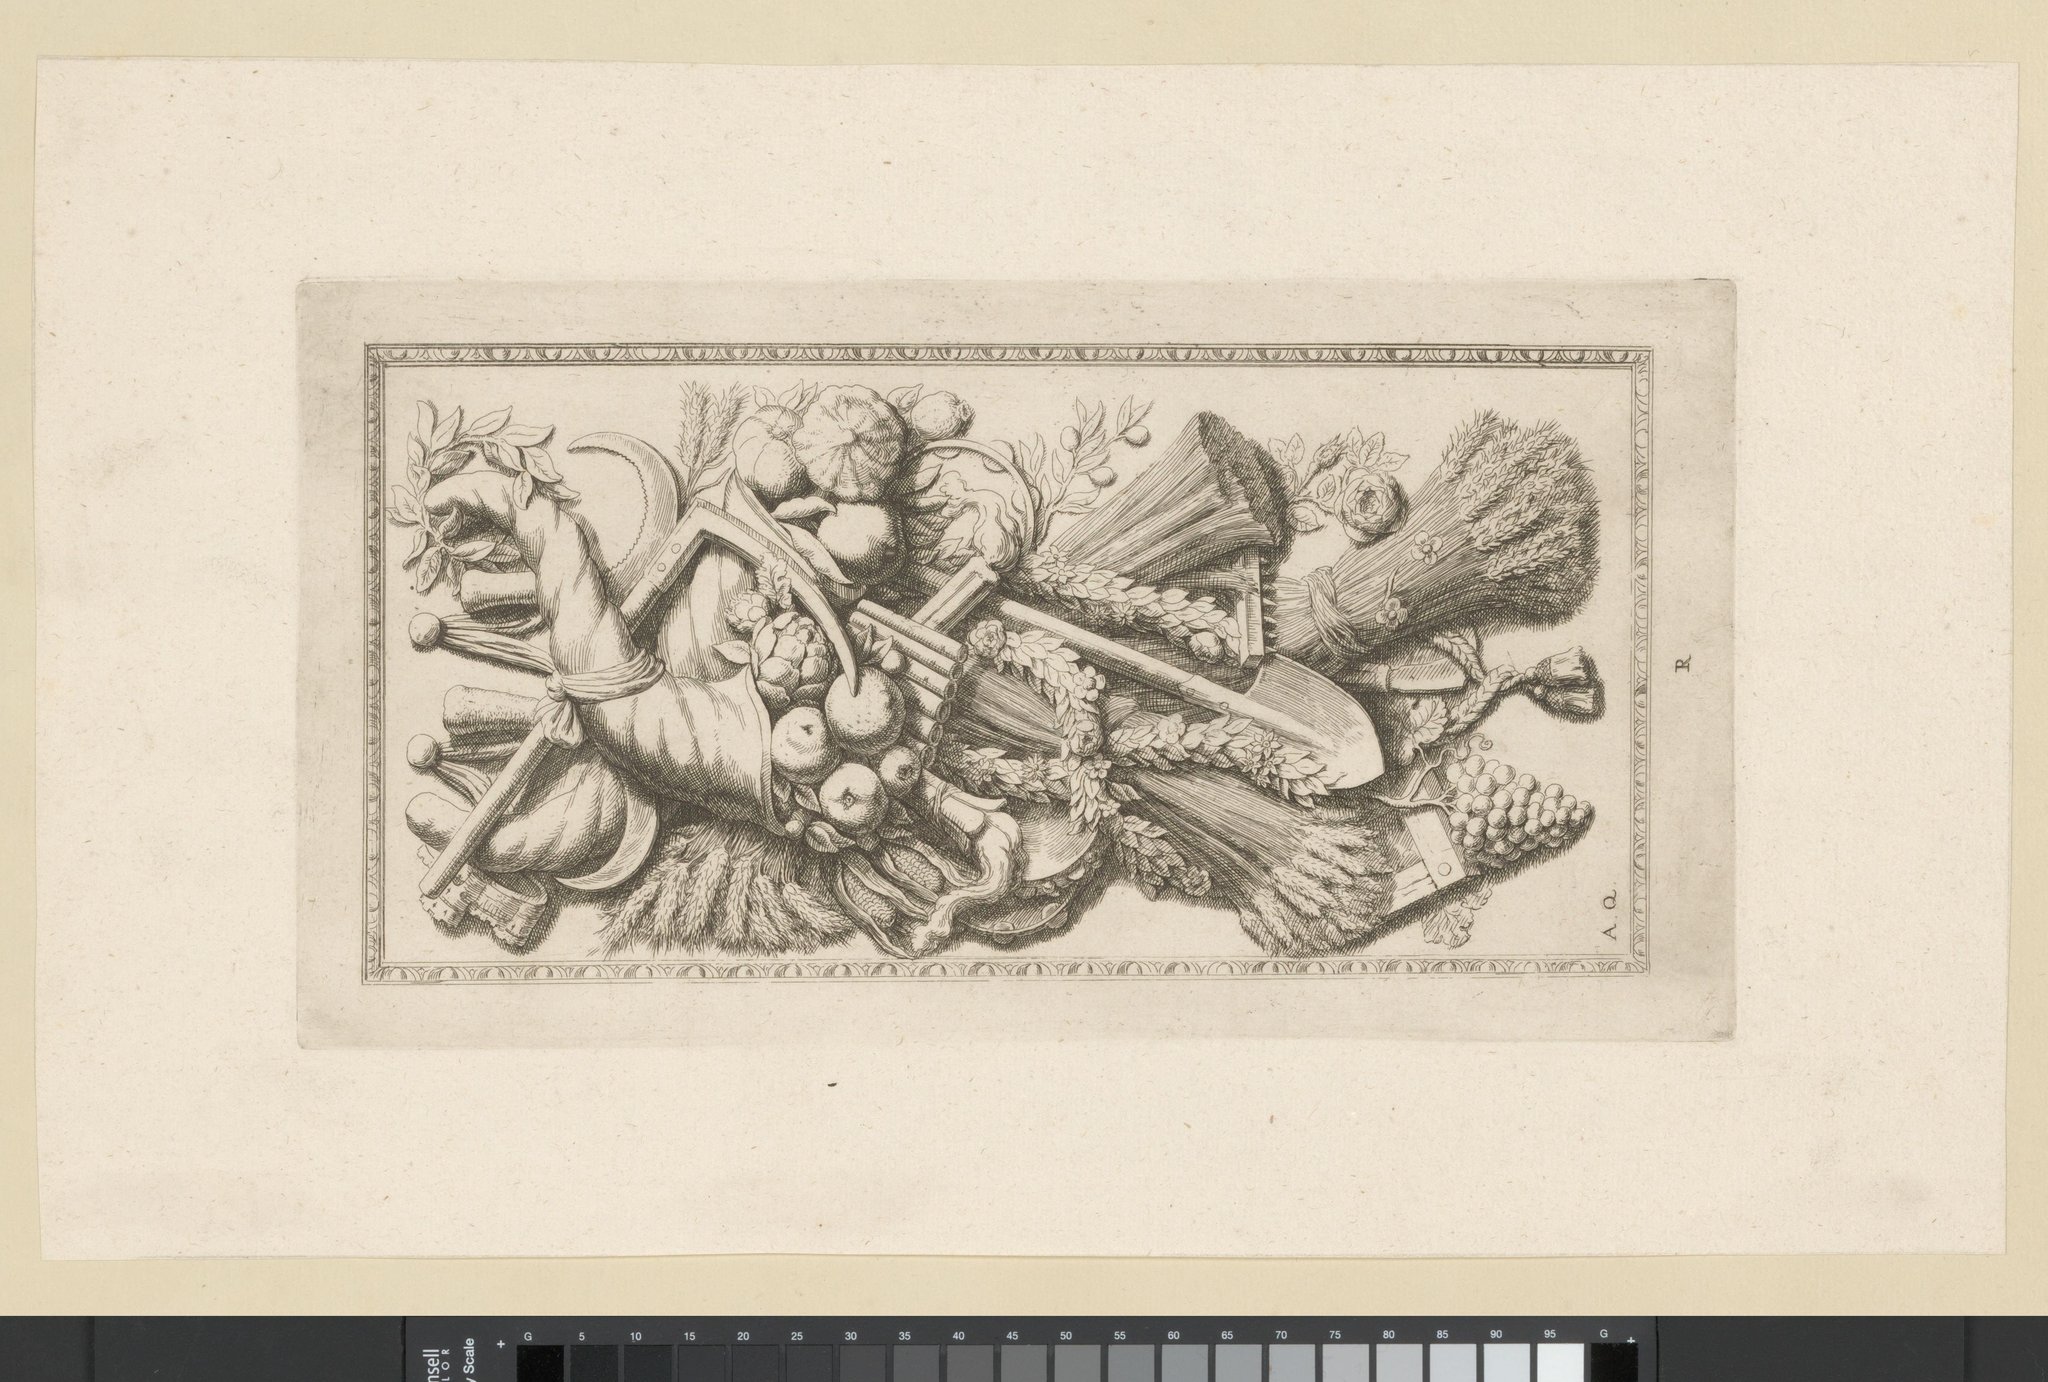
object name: print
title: Reliëf met attributen van Cybele voor op piëdestal in de oostelijke galerij van het Stadhuis op de Dam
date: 1655-1665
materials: paper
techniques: engraving, etching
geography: amsterdam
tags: 'cornucopia', horn of plenty, fruits and vegetables ~ ornament, townhall, agricultural implements, attributes of cybele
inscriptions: collector's mark: ‘16,56’ Lugt 1641b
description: Prent gebruikt in: Prima pars. Praecipuarum effigierum ac ornamentorum, amplissimae Curiae Amstelrodamensis (…) / Het eerste deel. Van de voornaemste Statuen ende Ciraten, vant konstijck Stadhuys van Amstelredam, tmeeste in marmer gemaeckt, door Artus Quellinus, Beelthouwer der voorseyde Stadt / La Premier Partie. De plusieurs Figures et ornements, de la Maison de Ville d'Amsterdam (…). Amsterdam: Artus Quellinus (I), 1655. Zie RP-P-AO-22-1-1 voor bijhorende titelpagina. Zie RP-P-AO-22-1-2 voor bijhorend register. Zie RP-P-AO-22-1A, RP-P-AO-22-1B, RP-P-AO-22-1C, RP-P-AO-22-1D-1, RP-P-AO-22-1D-2, RP-P-AO-22-1E, RP-P-AO-22-1F, RP-P-AO-22-1G, RP-P-AO-22-1H, RP-P-AO-22-1I, RP-P-AO-22-1K-1, RP-P-AO-22-1K-2, RP-P-AO-22-1K-3, RP-P-AO-22-1K-4, RP-P-AO-22-1K-5, RP-P-AO-22-1L-1, RP-P-AO-22-1L-2, RP-P-AO-22-1M-1, RP-P-AO-22-1M-2, RP-P-AO-22-1N-1, RP-P-AO-22-1N-2, RP-P-AO-22-1N-3, RP-P-AO-22-1N-4, RP-P-AO-22-1N-5, RP-P-AO-22-1O-1, RP-P-AO-22-1O-2, RP-P-AO-22-1O-3, RP-P-AO-22-1O-4, RP-P-AO-22-1P-1, RP-P-AO-22-1P-2, RP-P-AO-22-1P-3, RP-P-AO-22-1P-4, RP-P-AO-22-1Q-1, RP-P-AO-22-1Q-2, RP-P-AO-22-1Q-3, RP-P-AO-22-1Q-4, RP-P-AO-22-1R-1, RP-P-AO-22-1R-2, RP-P-AO-22-1R-3, RP-P-AO-22-1R-4, RP-P-AO-22-1S-1, RP-P-AO-22-1S-2, RP-P-AO-22-1S-3, RP-P-AO-22-1S-4, RP-P-AO-22-1S-5, RP-P-AO-22-1T-1 en RP-P-AO-22-1T-2 voor andere prenten uit deze publicatie. Zelfde staat van prent ook gebruikt in: Prima pars. Praecipuarum effigierum ac ornamentorum, amplissimae Curiae Amstelrodamensis (…) / Het eerste deel. Van de voornaemste Statuen ende Ciraten, vant konstijck Stadhuys van Amstelredam, tmeeste in marmer gemaeckt, door Artus Quellinus, Beelthouwer der voorseyde Stadt / La Premier Partie. De plusieurs Figures et ornements, de la Maison de Ville d'Amsterdam (…). Amsterdam: Frederik de Wit, 1665. Latere staat van prent ook gebruikt in: Architecture peinture et sculpture de la Maison de Ville d'Amsterdam, representee en CIX. figures en taille-douce (…). Amsterdam: David Mortier, 1719. En in: Architecture peinture et sculpture de la Maison de Ville d'Amsterdam, representee en CIX. figures en taille-douce (…). Amsterdam: Gerard Valck, 1719. En in: Bouw schilder en beeldhouwkonst, van het Stadhuis te Amsteldam, vertoont in CIX figuuren (…). Amsterdam: Covens & Mortier & Covens Jr., s.a. (1774-1783).